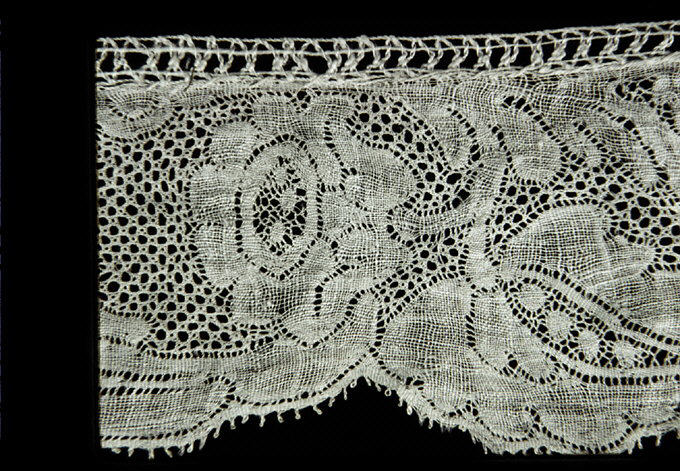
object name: strip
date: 1701-1733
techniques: lace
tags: flowers,leaves